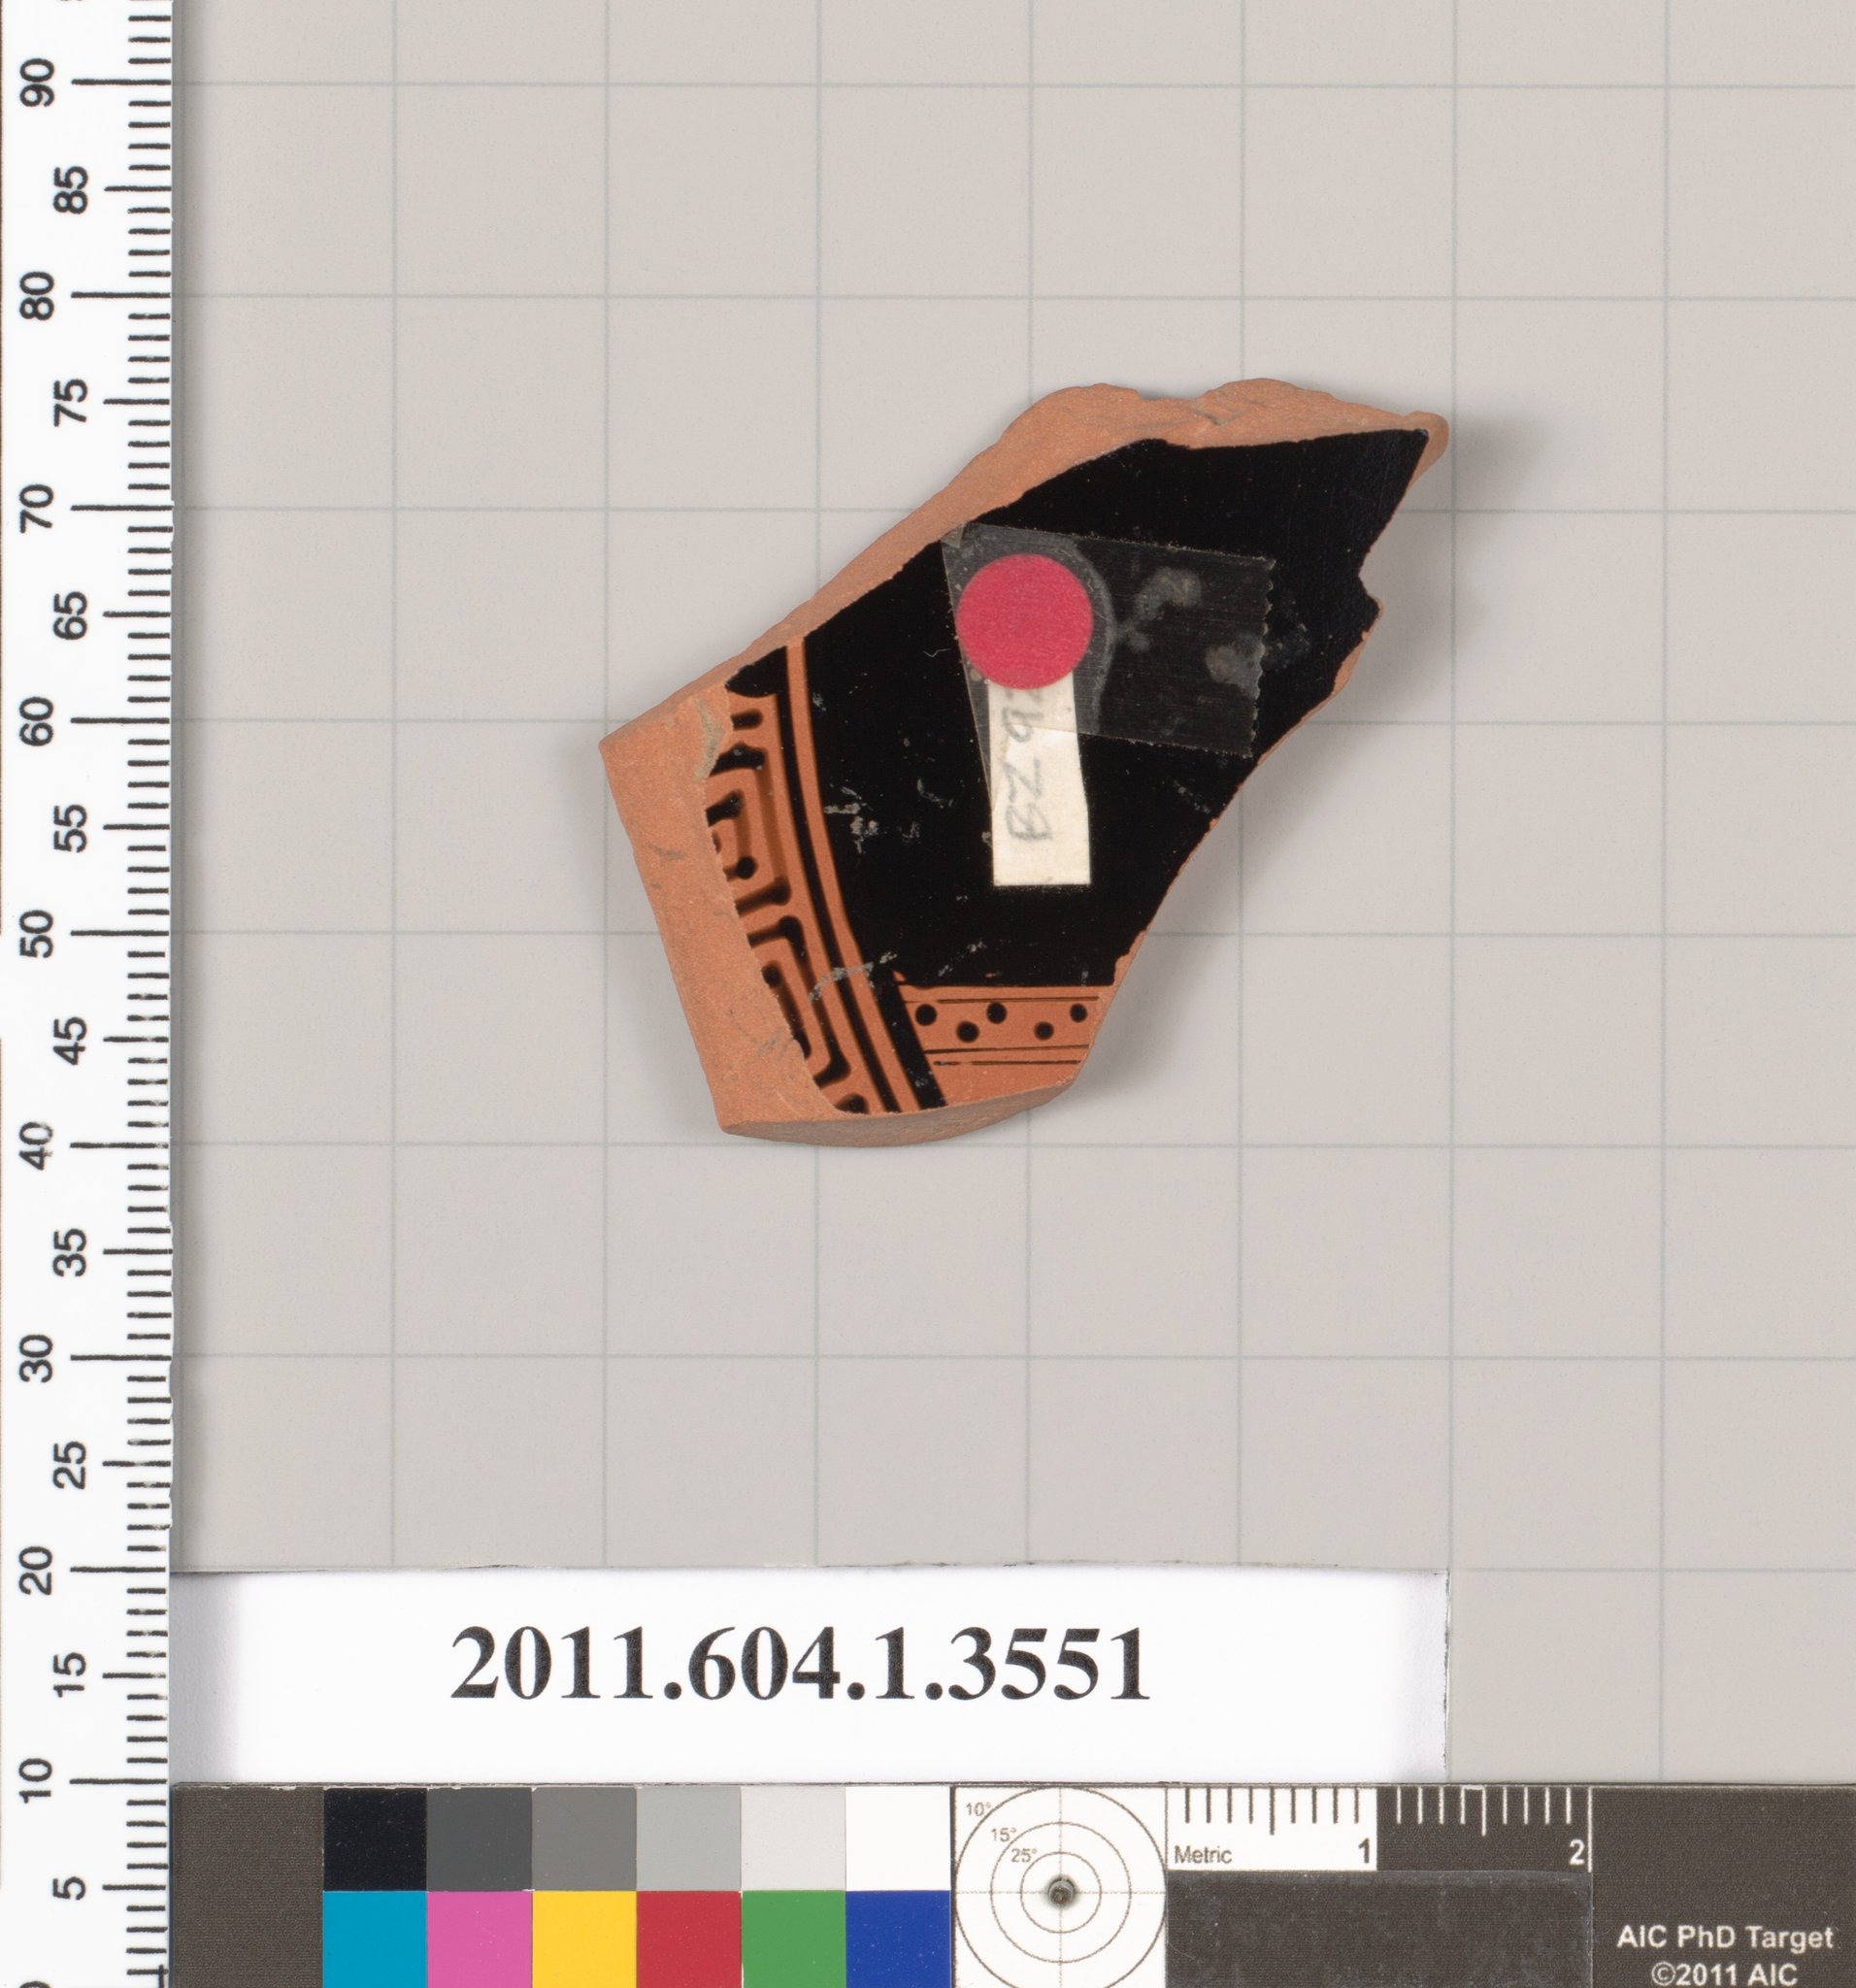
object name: kylix fragment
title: Terracotta fragment of a kylix (drinking cup)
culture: greek, attic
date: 510-490 BCE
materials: terracotta